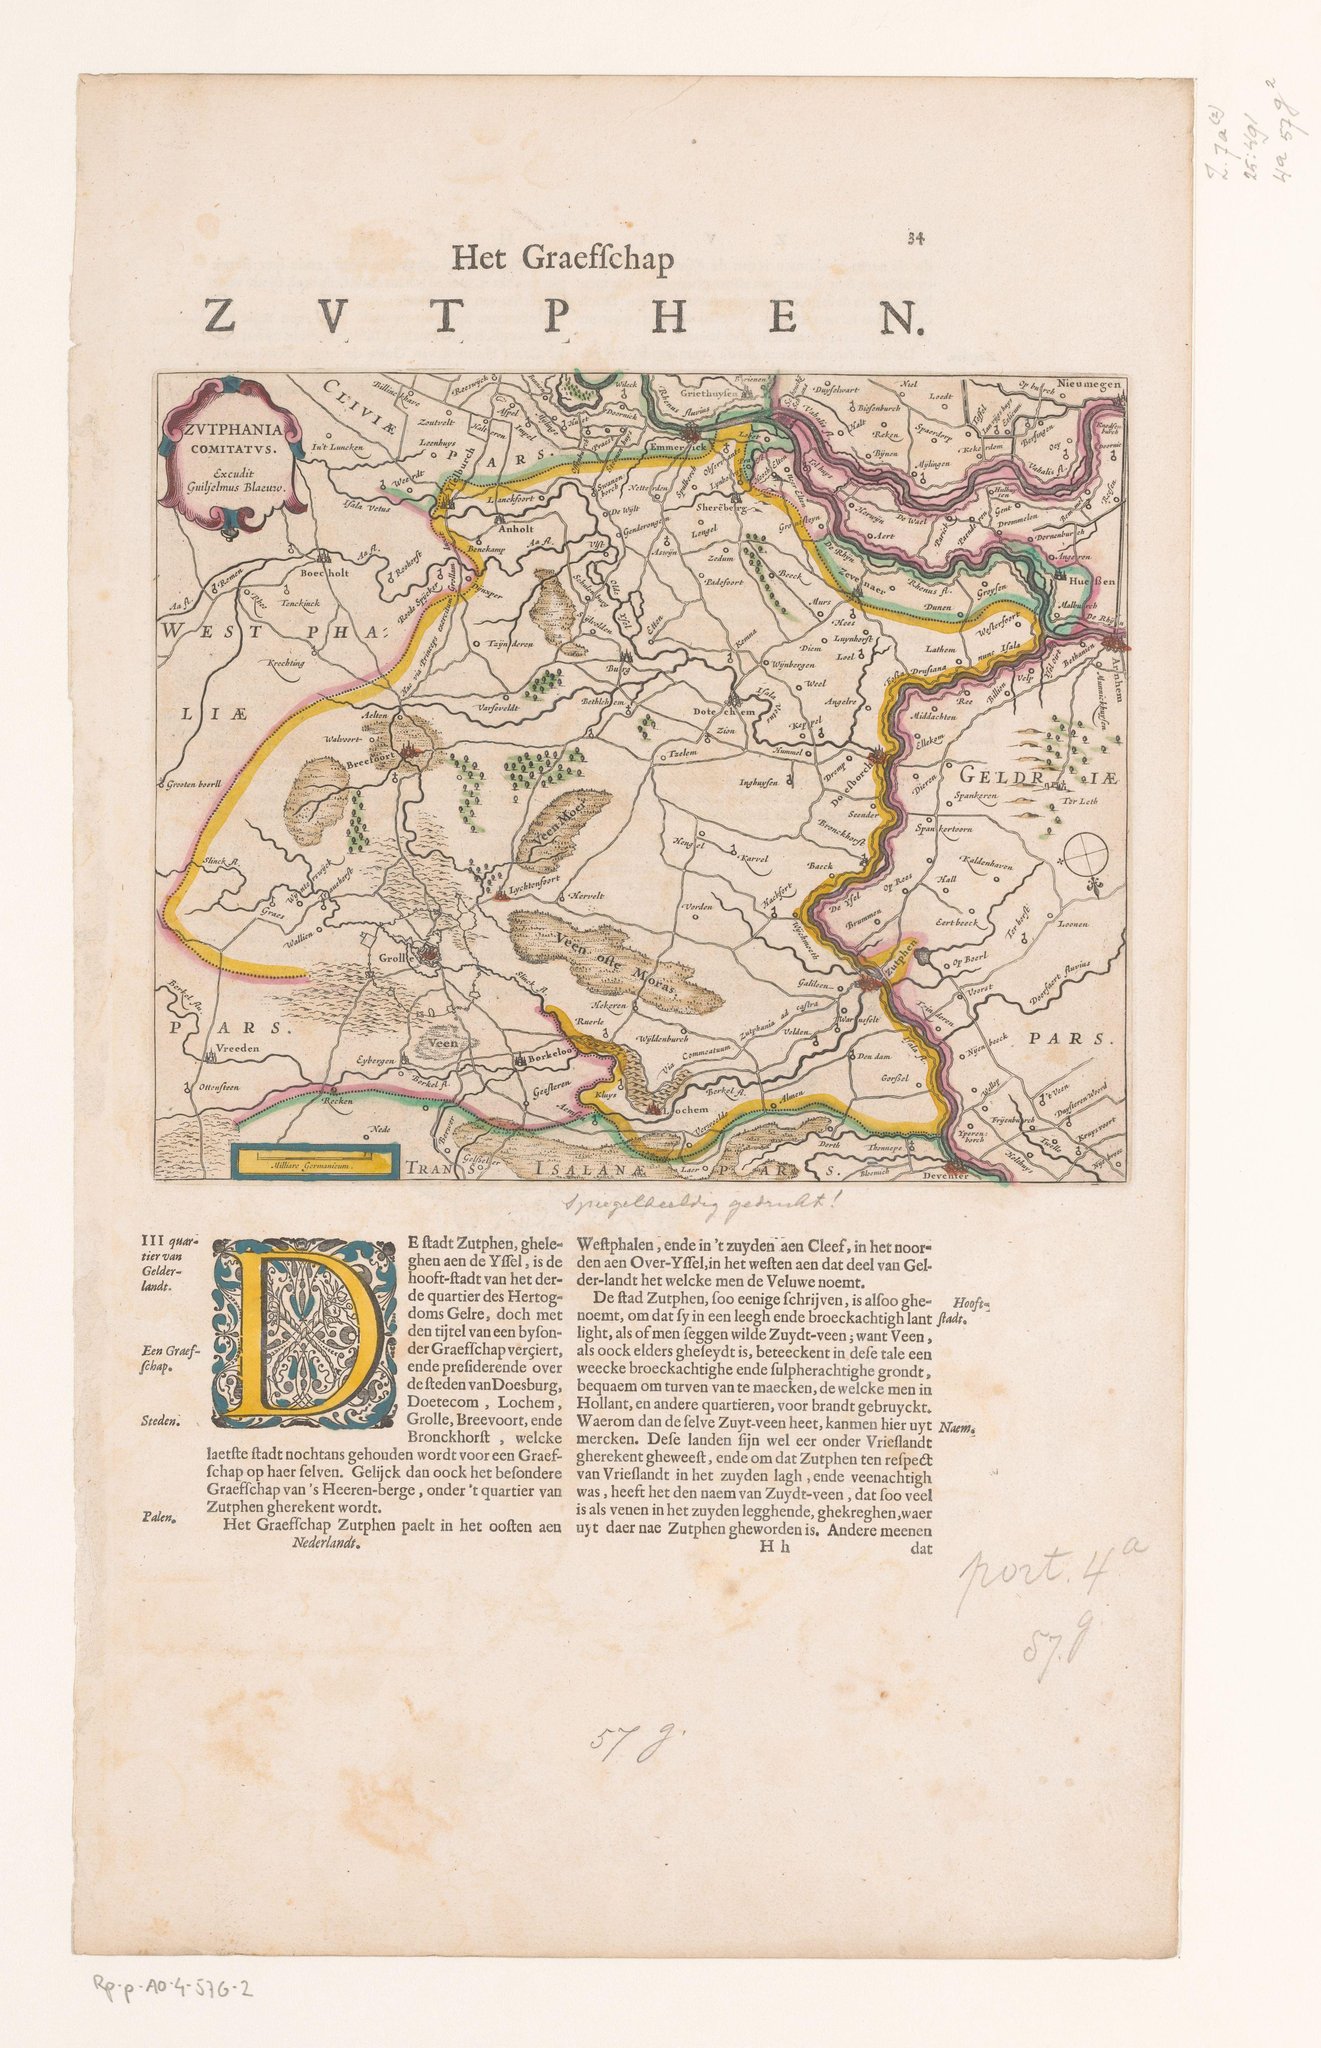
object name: map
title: Kaart van het graafschap Zutphen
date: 1647-1661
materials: paper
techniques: engraving, etching, hand coloring, letterpress printing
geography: amsterdam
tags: maps of separate countries or regions, gelderland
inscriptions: collector's mark: Lugt 2228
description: Prent gebruikt in: Blaeu, Willem Janszoon en Johannes Willemszoon Blaeu. Toonneel des aerdrycx, ofte nieuwe Atlas, dat is de beschryving van alle landen. 4 delen. Amsterdam: Johannes Willemszoon Blaeu, 1647-1650, dl. 1 (1647-1648). Of in: Blaeu, Willem Janszoon en Johannes Willemszoon Blaeu. Toonneel des aerdrycx, ofte nieuwe Atlas, dat is de beschryving van alle landen. 5 delen. Amsterdam: Johannes Willemszoon Blaeu, 1649-1658, dl. 1 (1649). Of in: Blaeu, Willem Janszoon en Johannes Willemszoon Blaeu. Toonneel des aerdrycx, ofte nieuwe Atlas, dat is de beschryving van alle landen. 6 delen. Amsterdam: Johannes Willemszoon Blaeu, 1658-1661, dl. 1 (1658-1661).